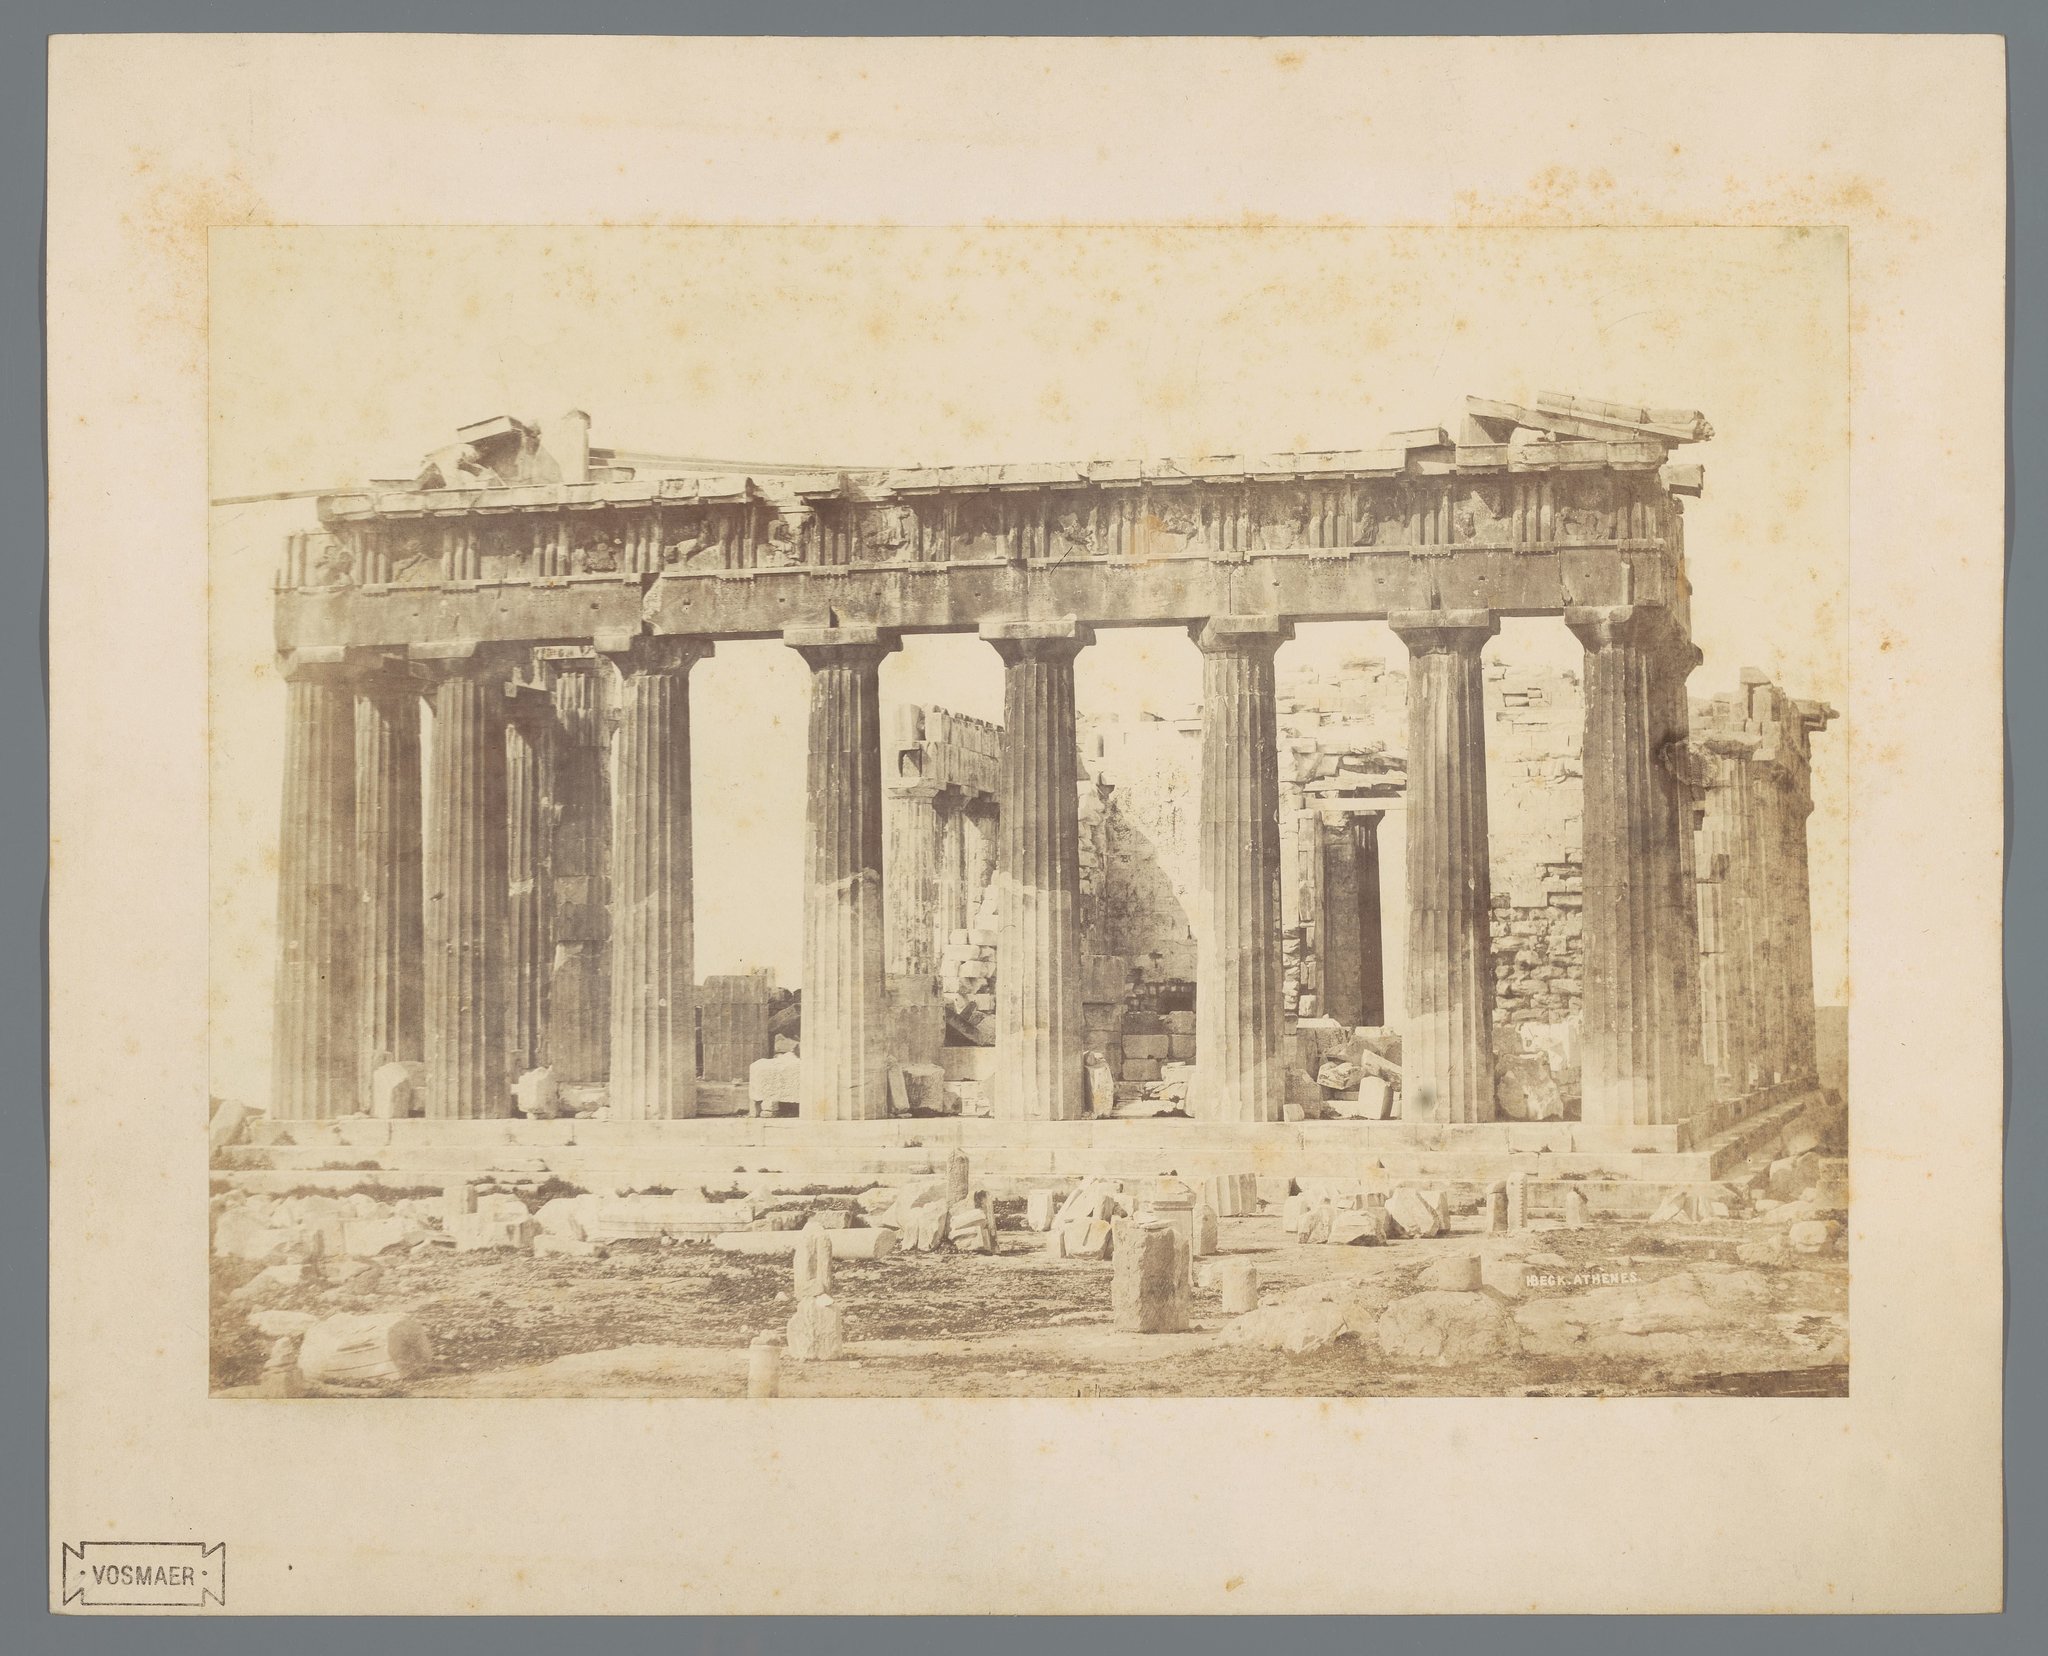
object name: photograph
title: Parthenon op de Akropolis van Athene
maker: henri beck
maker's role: fotograaf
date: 1850-1860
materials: cardboard, photographic support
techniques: salted paper print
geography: athens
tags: ruin of a building ~ architecture, places and objects of worship ~ non-christian religions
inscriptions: collector's mark: ‘VOSMAER’